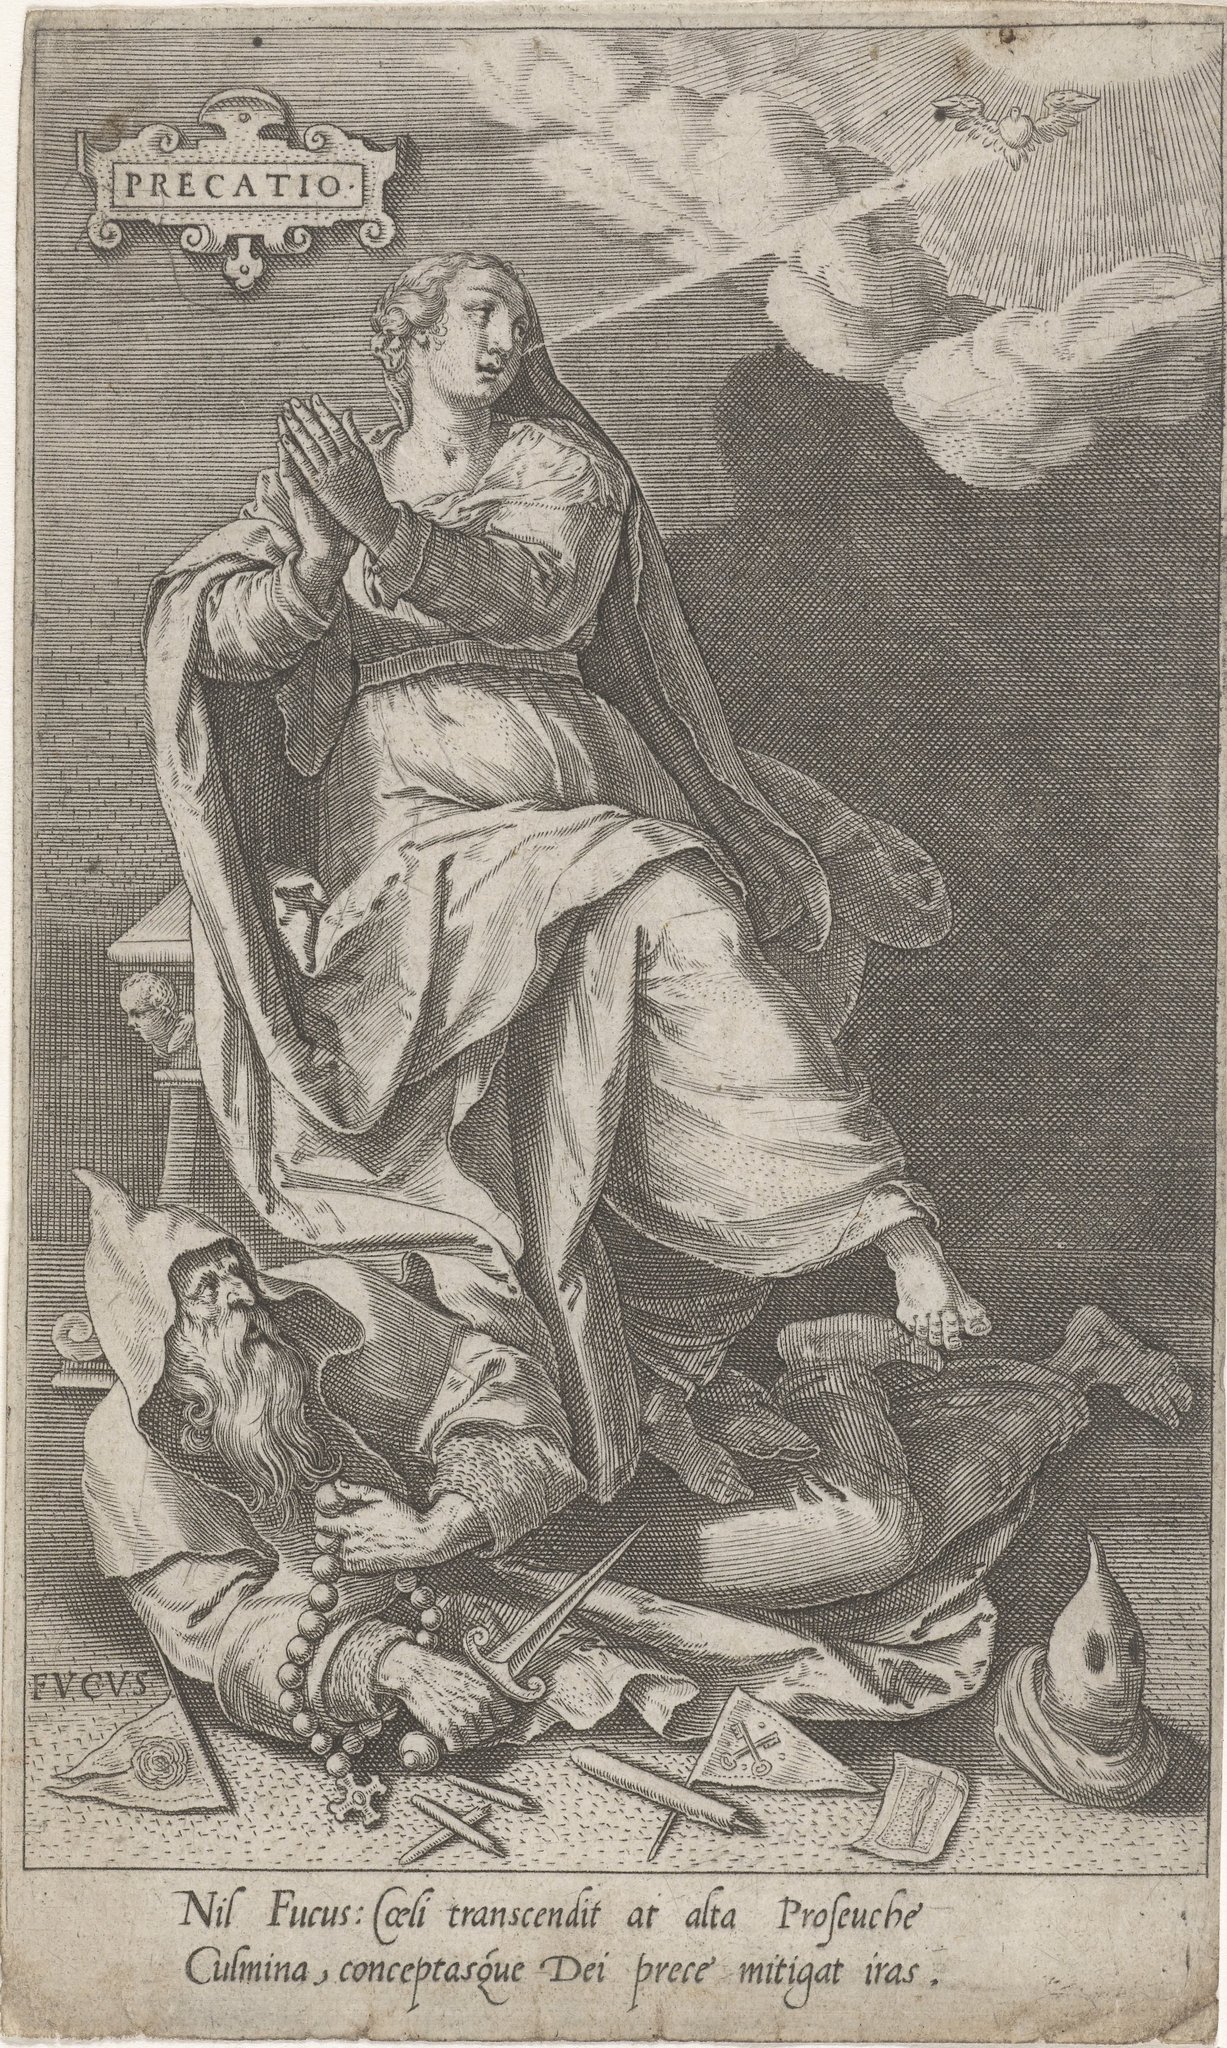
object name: print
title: Gebed (Precatio) overwint Schijnheiligheid (Fucus)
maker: johann sadeler (i)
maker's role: print maker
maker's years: 1550-1600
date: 1579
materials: paper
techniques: engraving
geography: antwerp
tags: false church personified, (private) prayer; 'oratione', 'preghiere', 'preghiere a dio' (ripa) (+ holy ghost (as a dove)), aids for prayer, e.g. rosary, monk(s), friar(s), candle, dissimulation, hypocrisy; 'hippocresia', 'simulatione' (ripa)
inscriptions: collector's mark: Lugt 2228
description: De personificatie Gebed (Precatio), met haar handen gevouwen. Ze kijkt naar de verschijning van de Heilige Geest als duif in de rechterbovenhoek. Gebed vertrapt de personificatie van Schijnheiligheid (Fucus), een monnik met een rozenkrans en een dolk. Rondom hem liggen attributen van de Rooms-Katholieke Kerk.